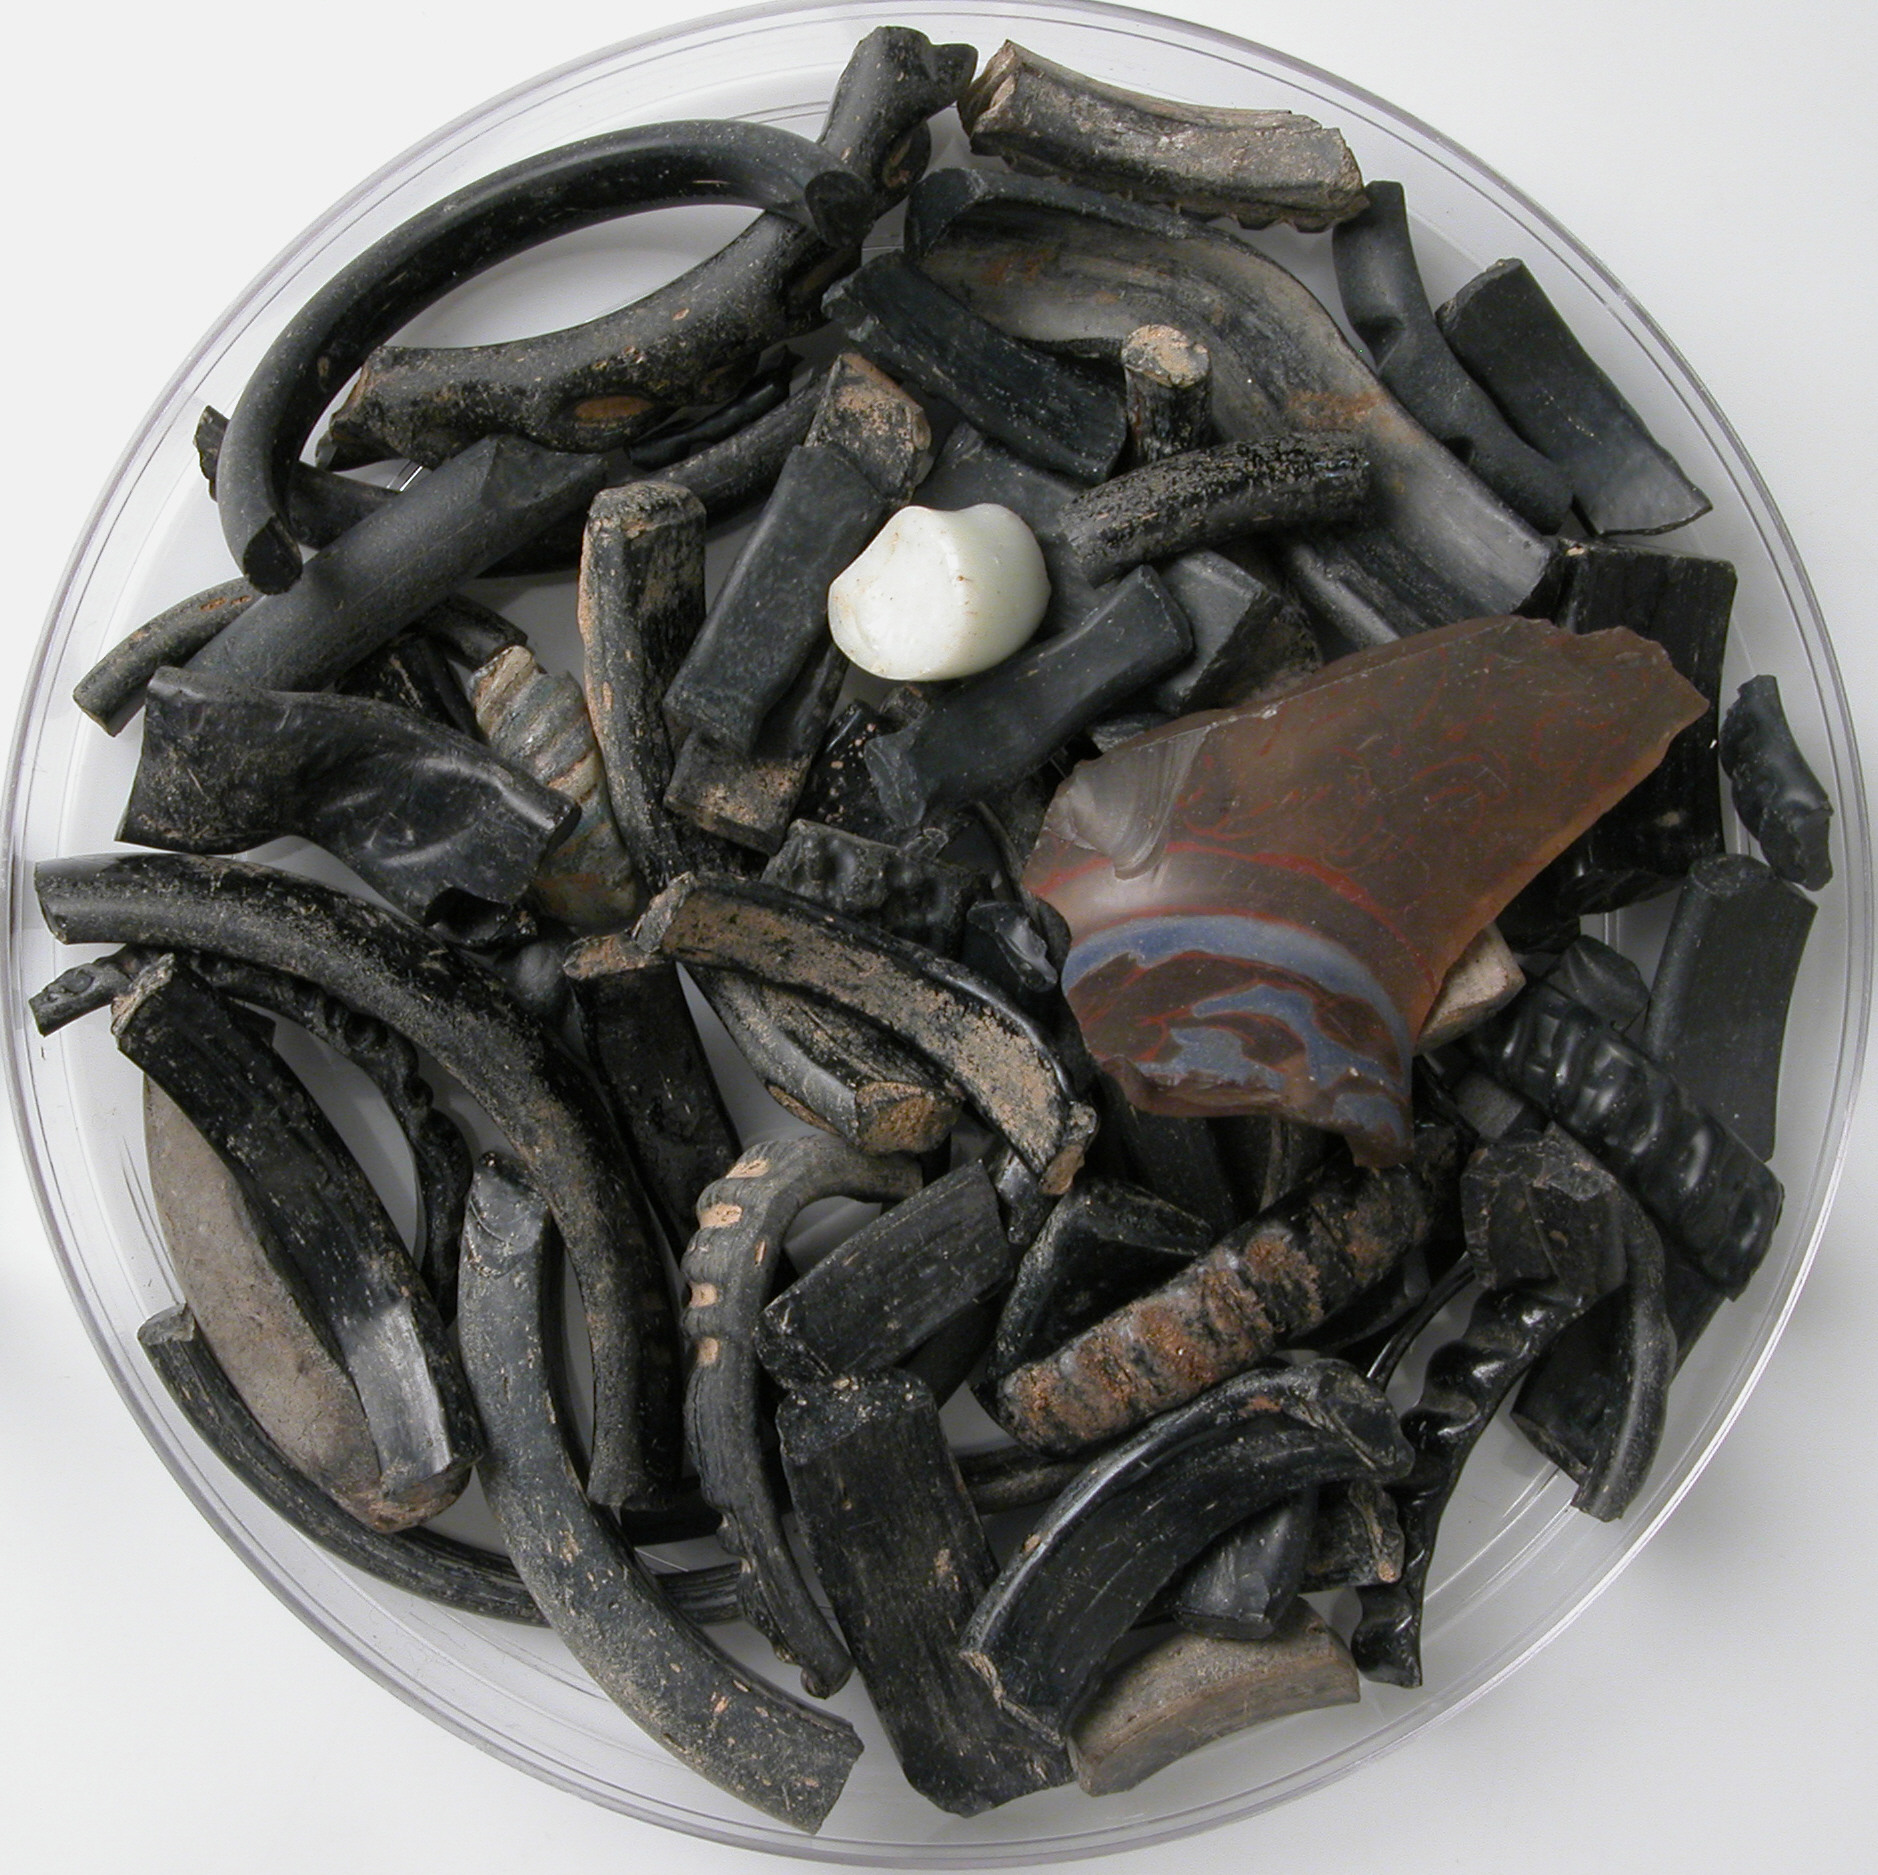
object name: fragment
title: Vessel Fragments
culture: coptic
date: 301-700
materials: glass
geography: egypt